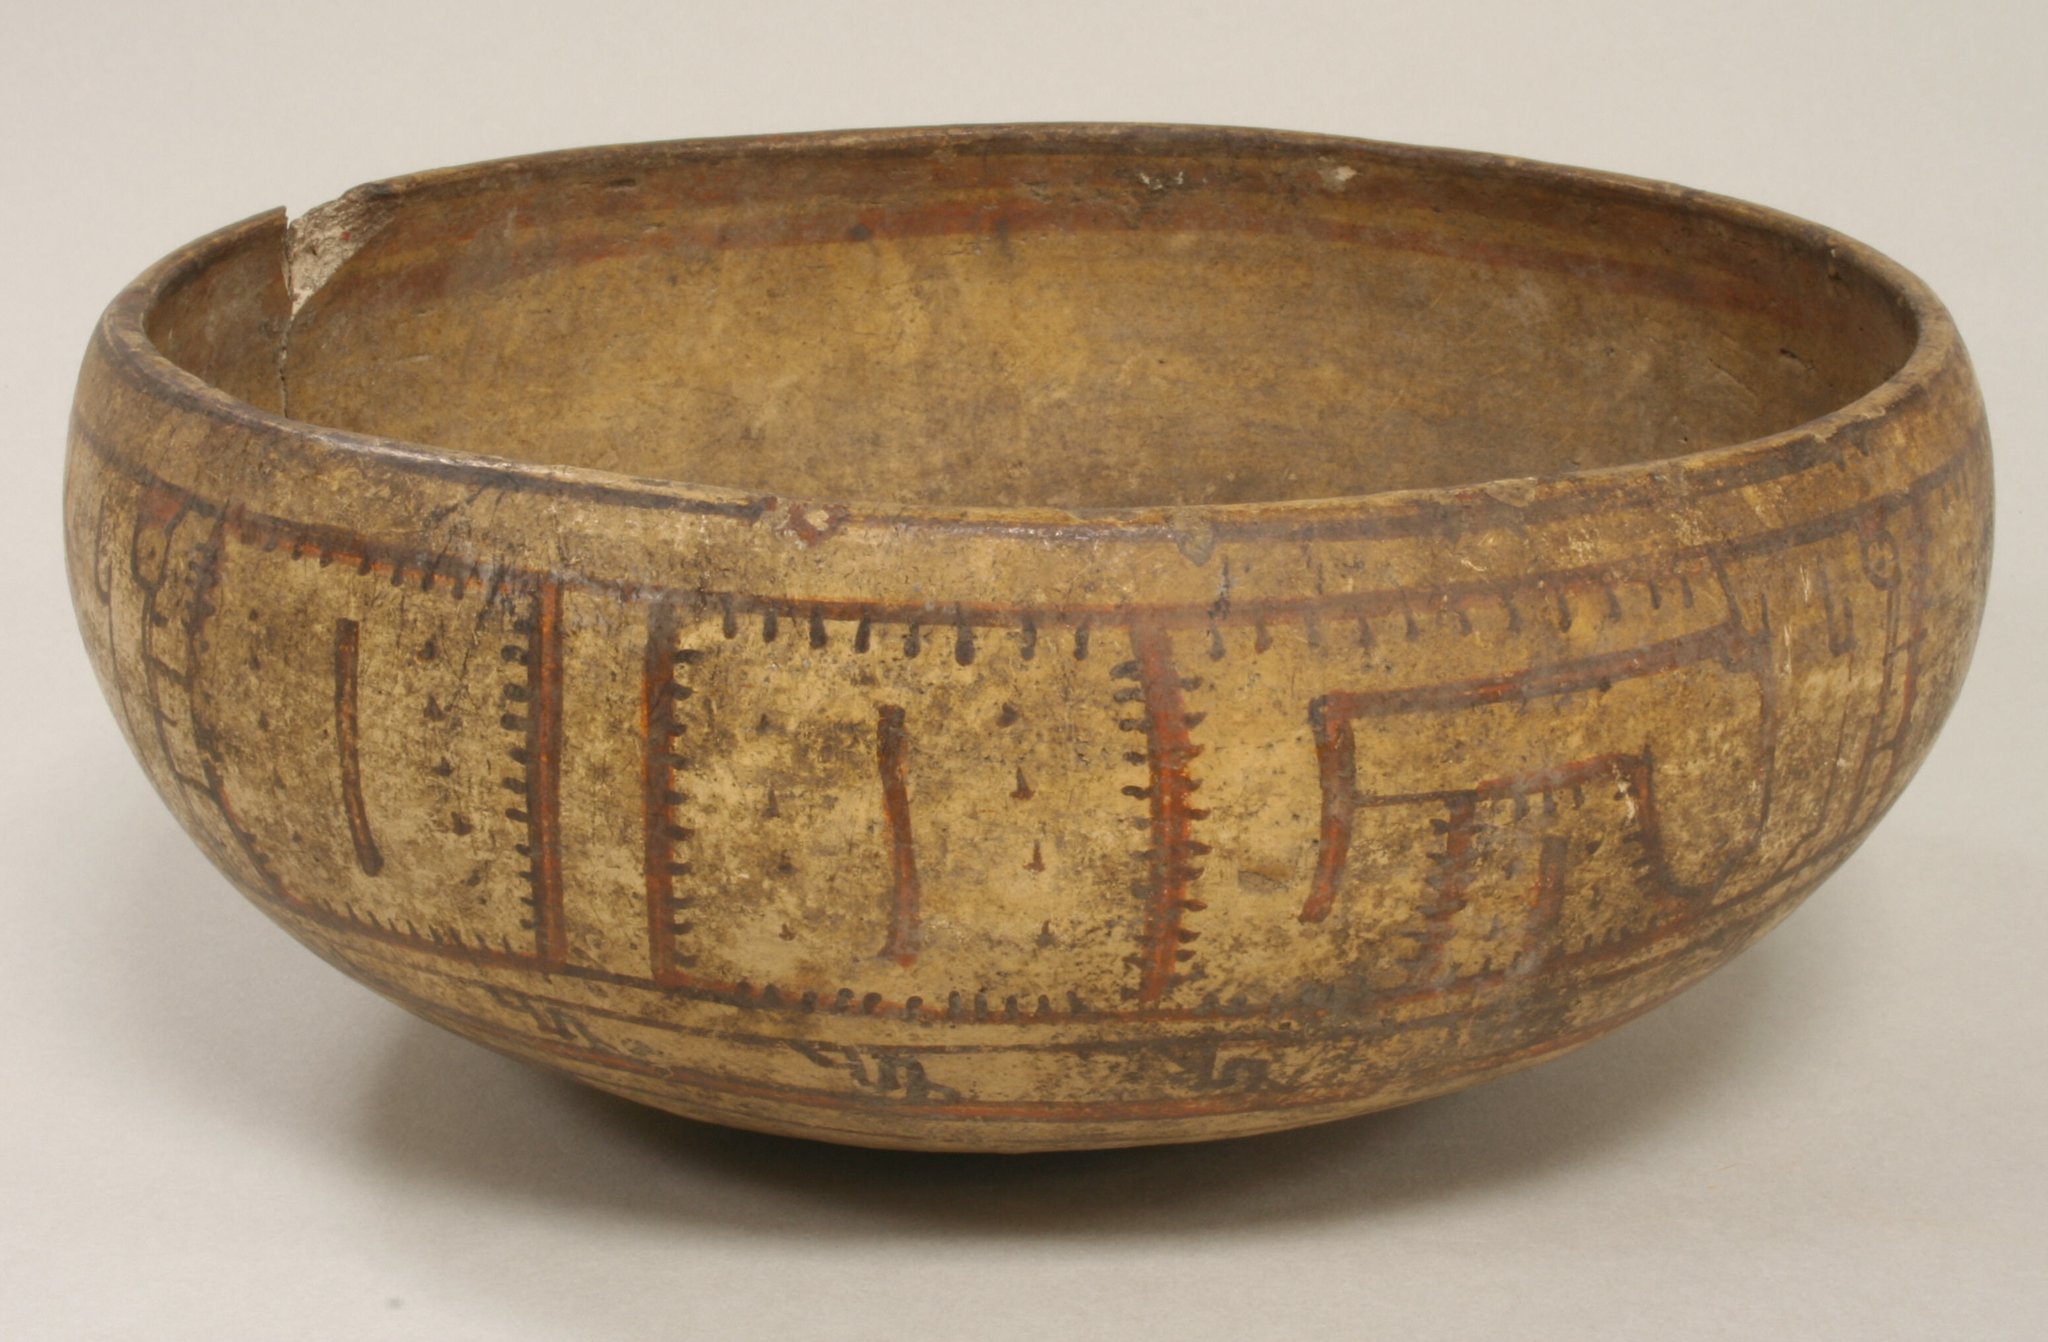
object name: bowl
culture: nicaragua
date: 1101-1500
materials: ceramic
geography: nicaragua